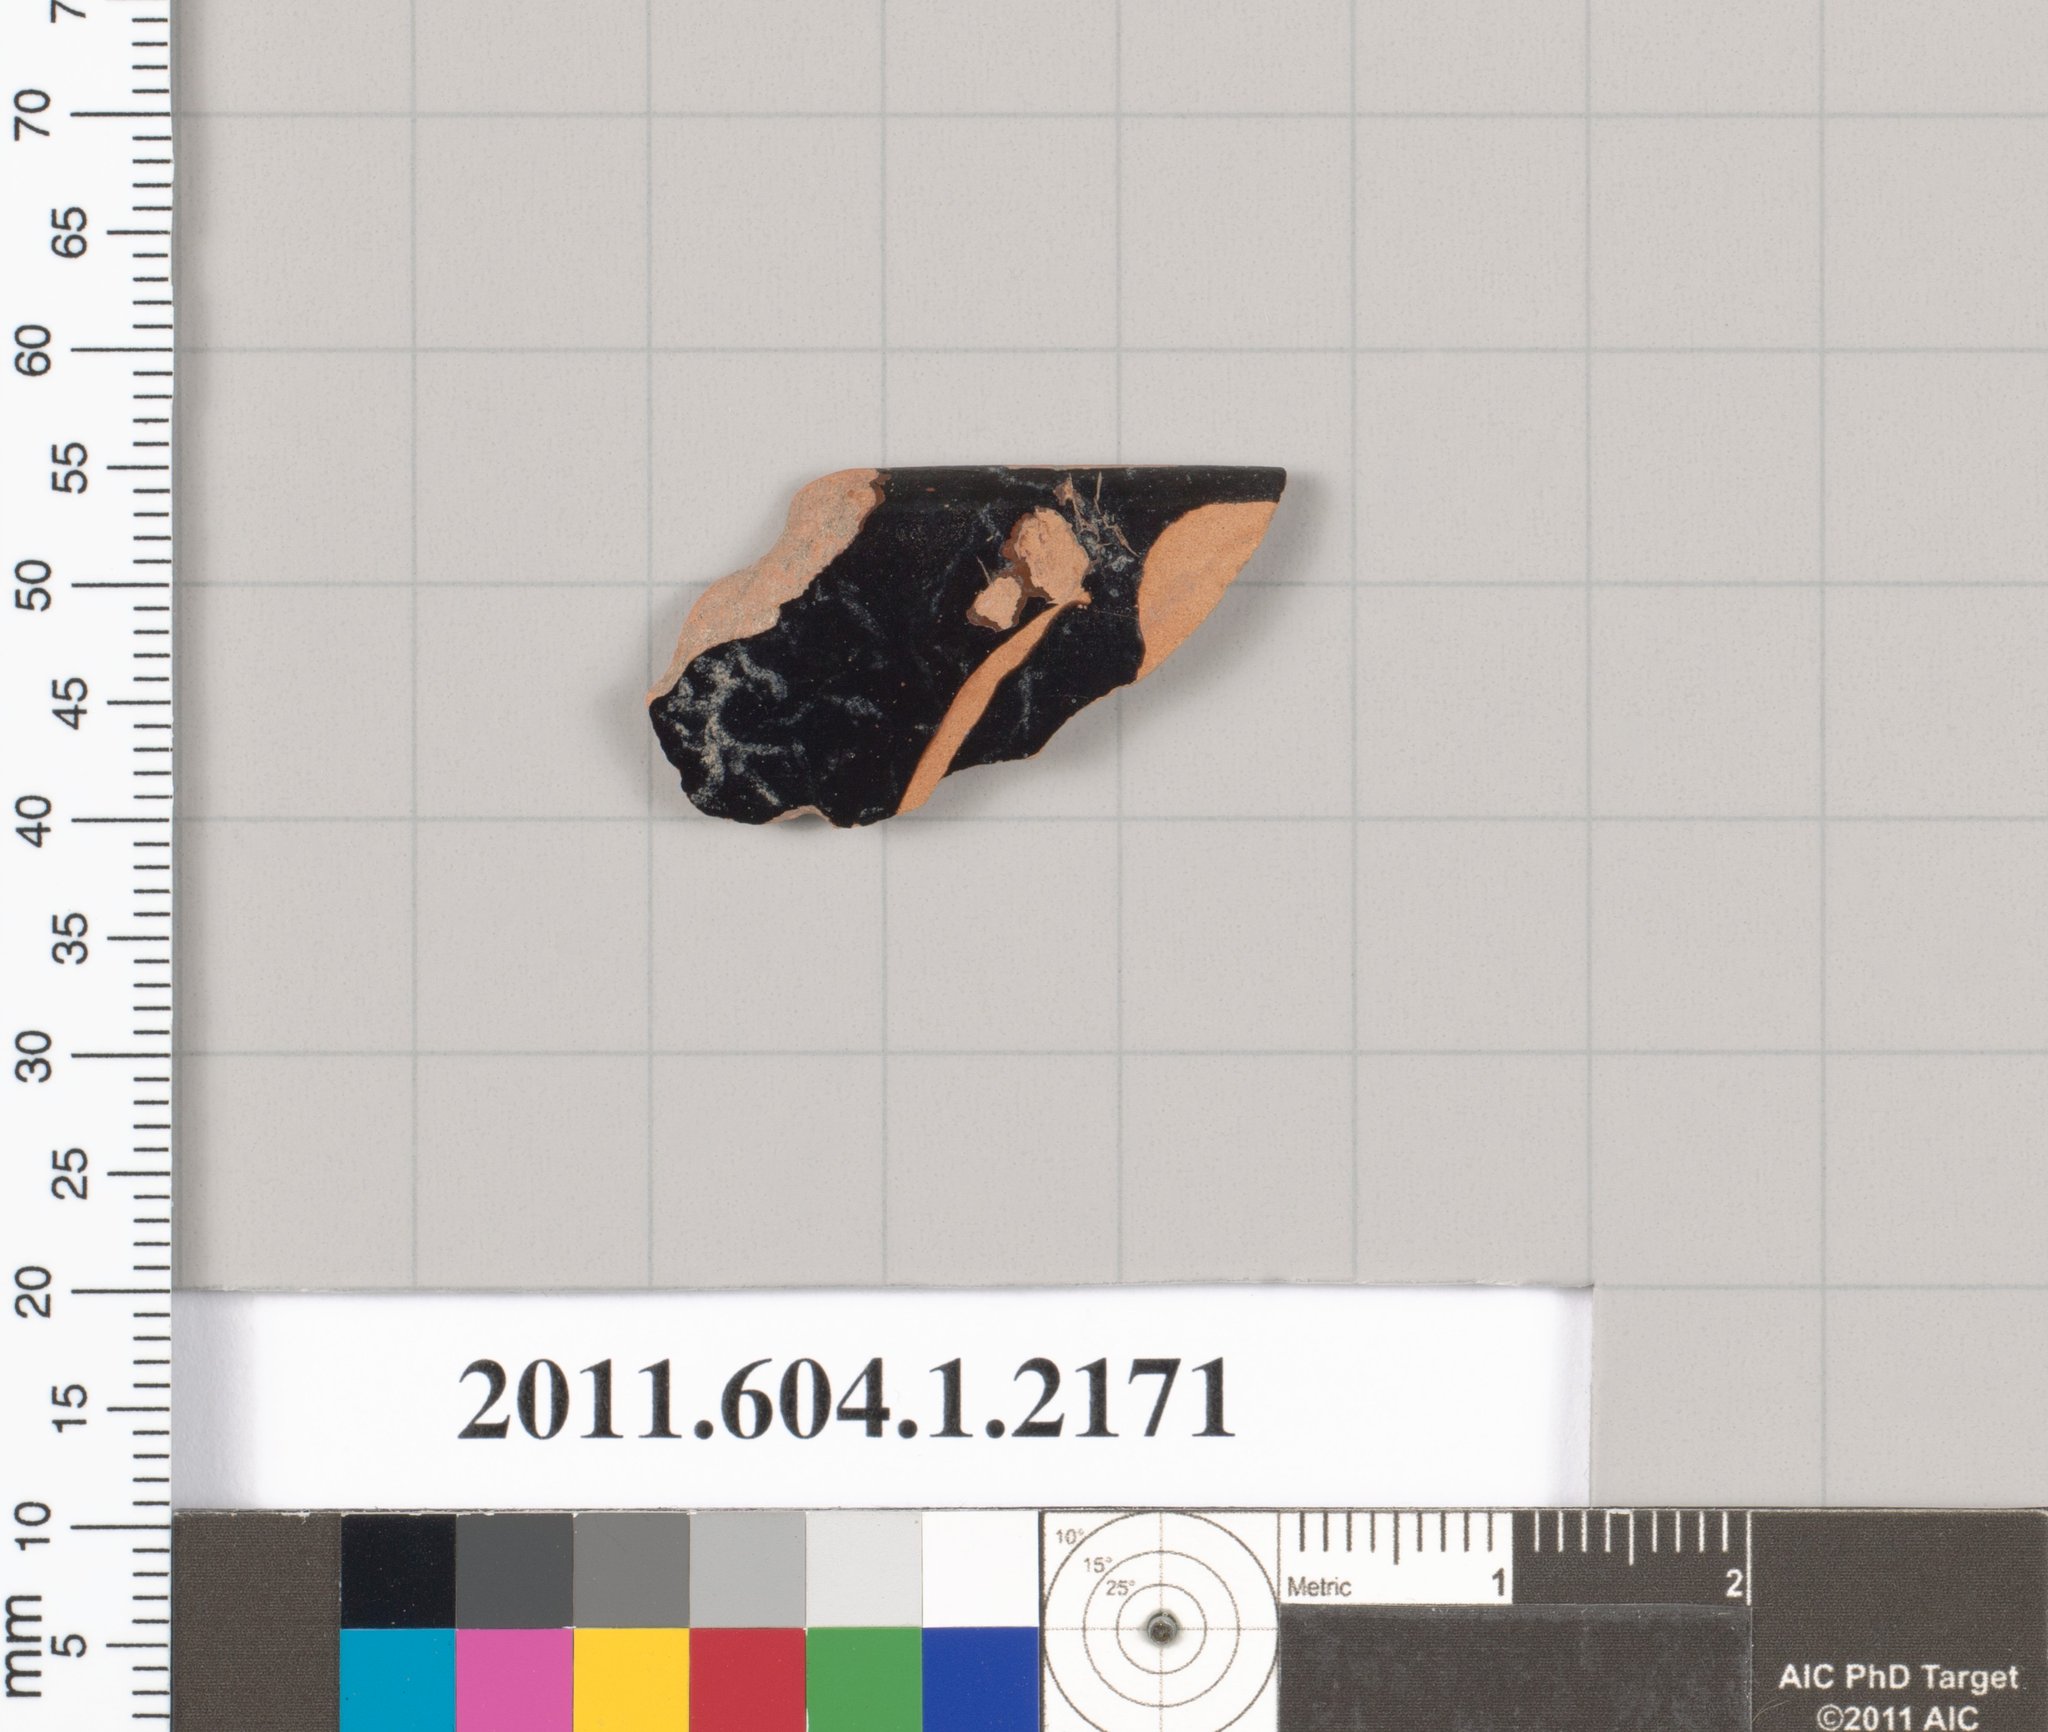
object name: kylix fragment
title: Terracotta rim fragment of a kylix (drinking cup)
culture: greek, attic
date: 500-401 BCE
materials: terracotta